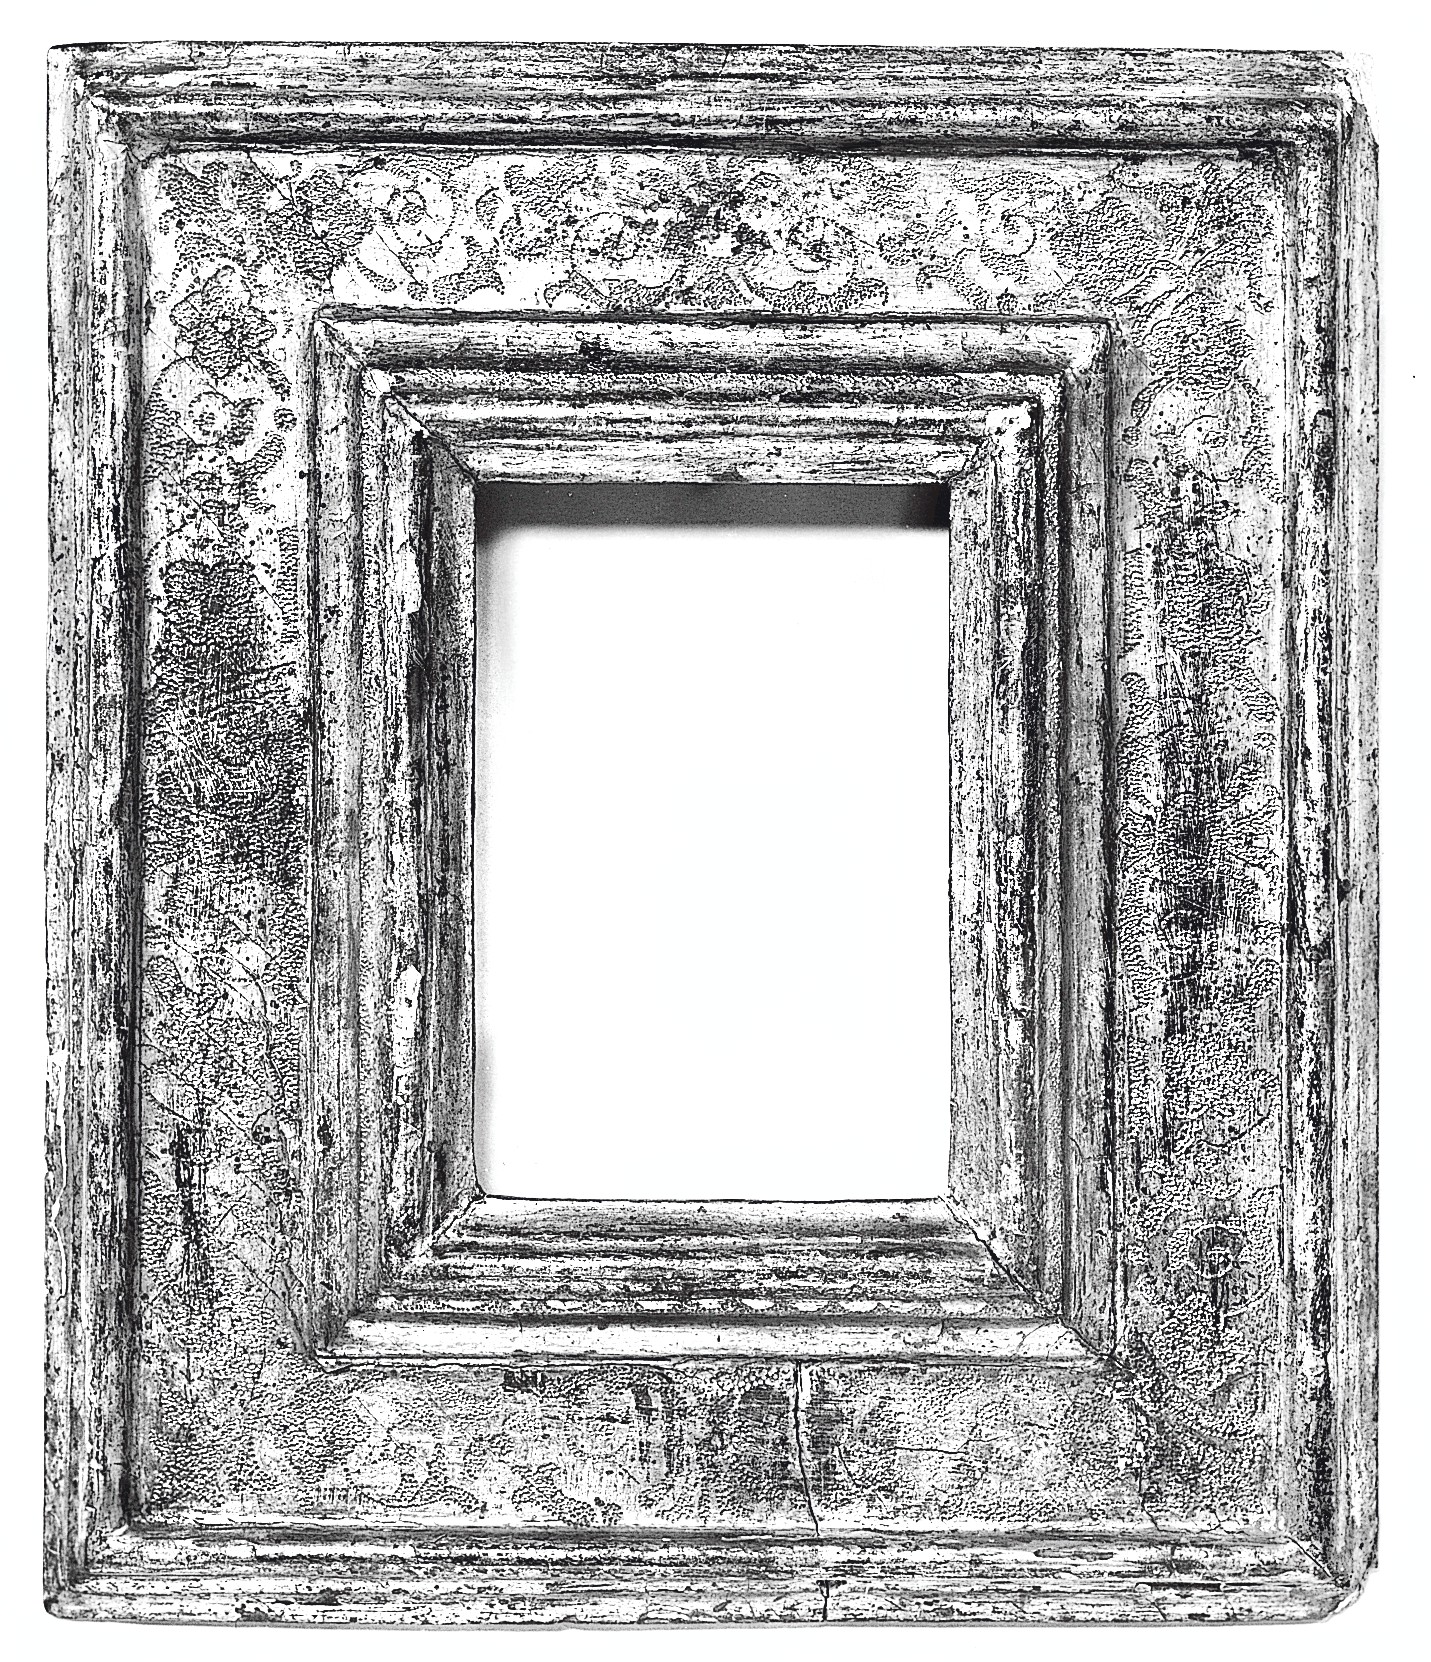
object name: frame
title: Reverse frame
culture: italian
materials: wood